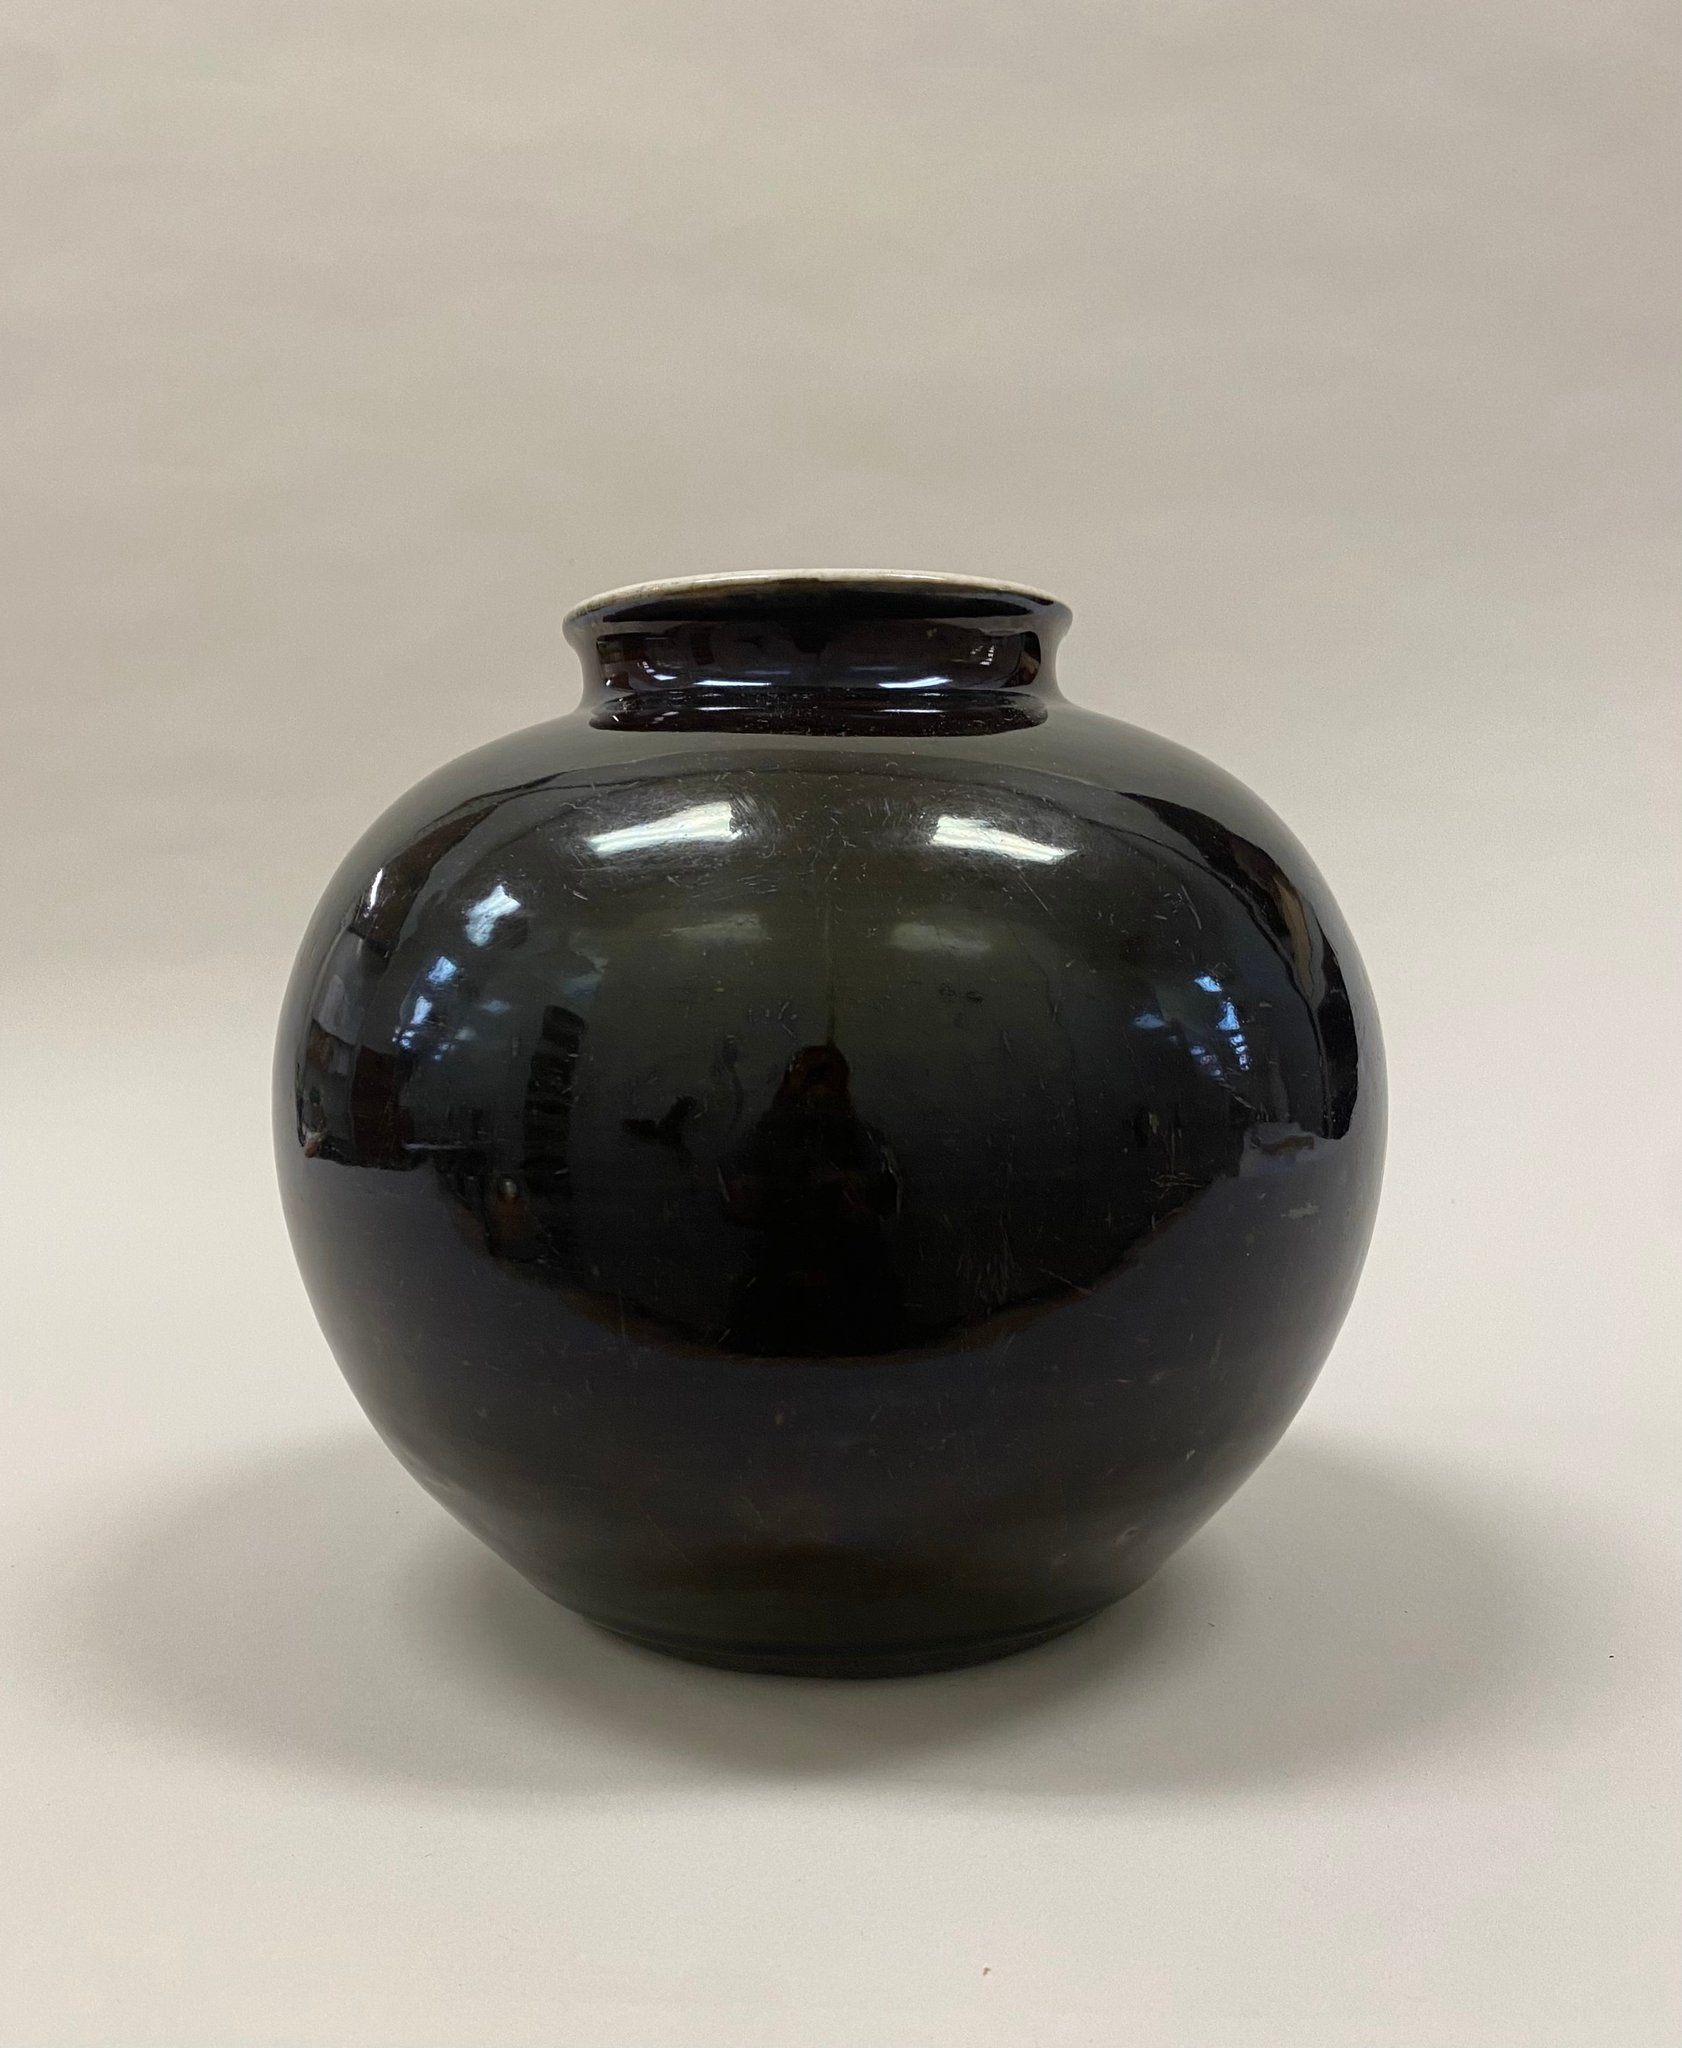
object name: jar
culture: chinese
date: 1701-1800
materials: glaze, porcelain